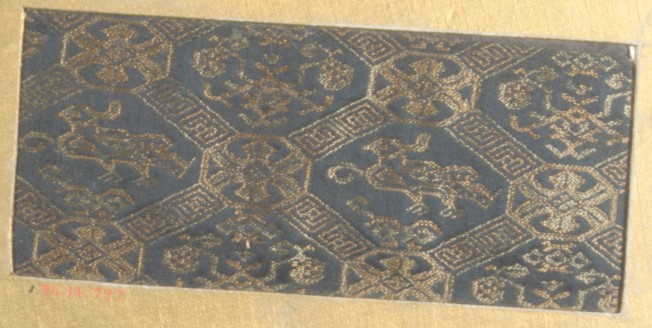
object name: piece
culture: japanese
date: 1701-1900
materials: silk